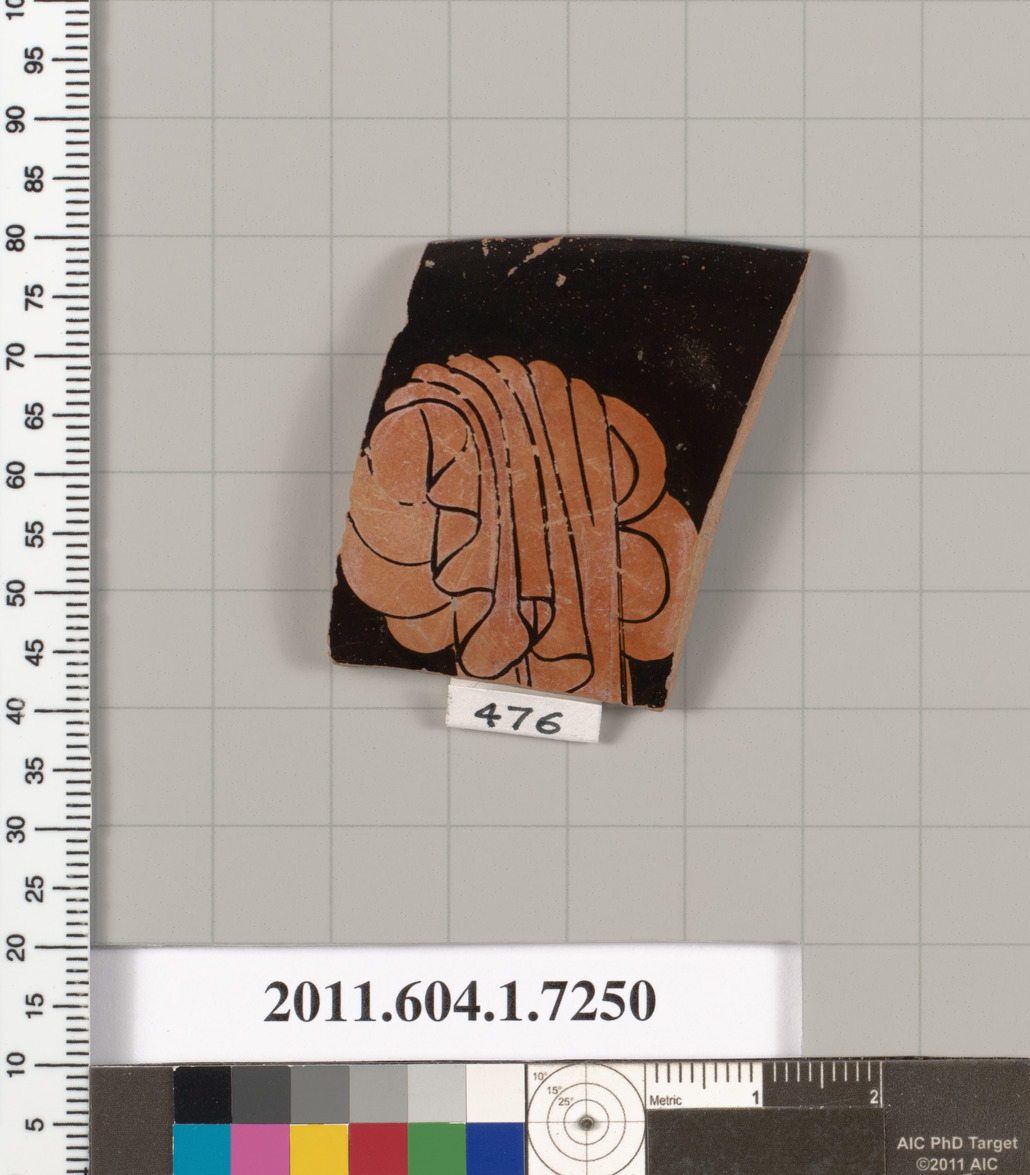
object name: kylix fragment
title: Terracotta rim fragment of a kylix (drinking cup)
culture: greek, attic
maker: makron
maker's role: artist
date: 500-480 BCE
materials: terracotta